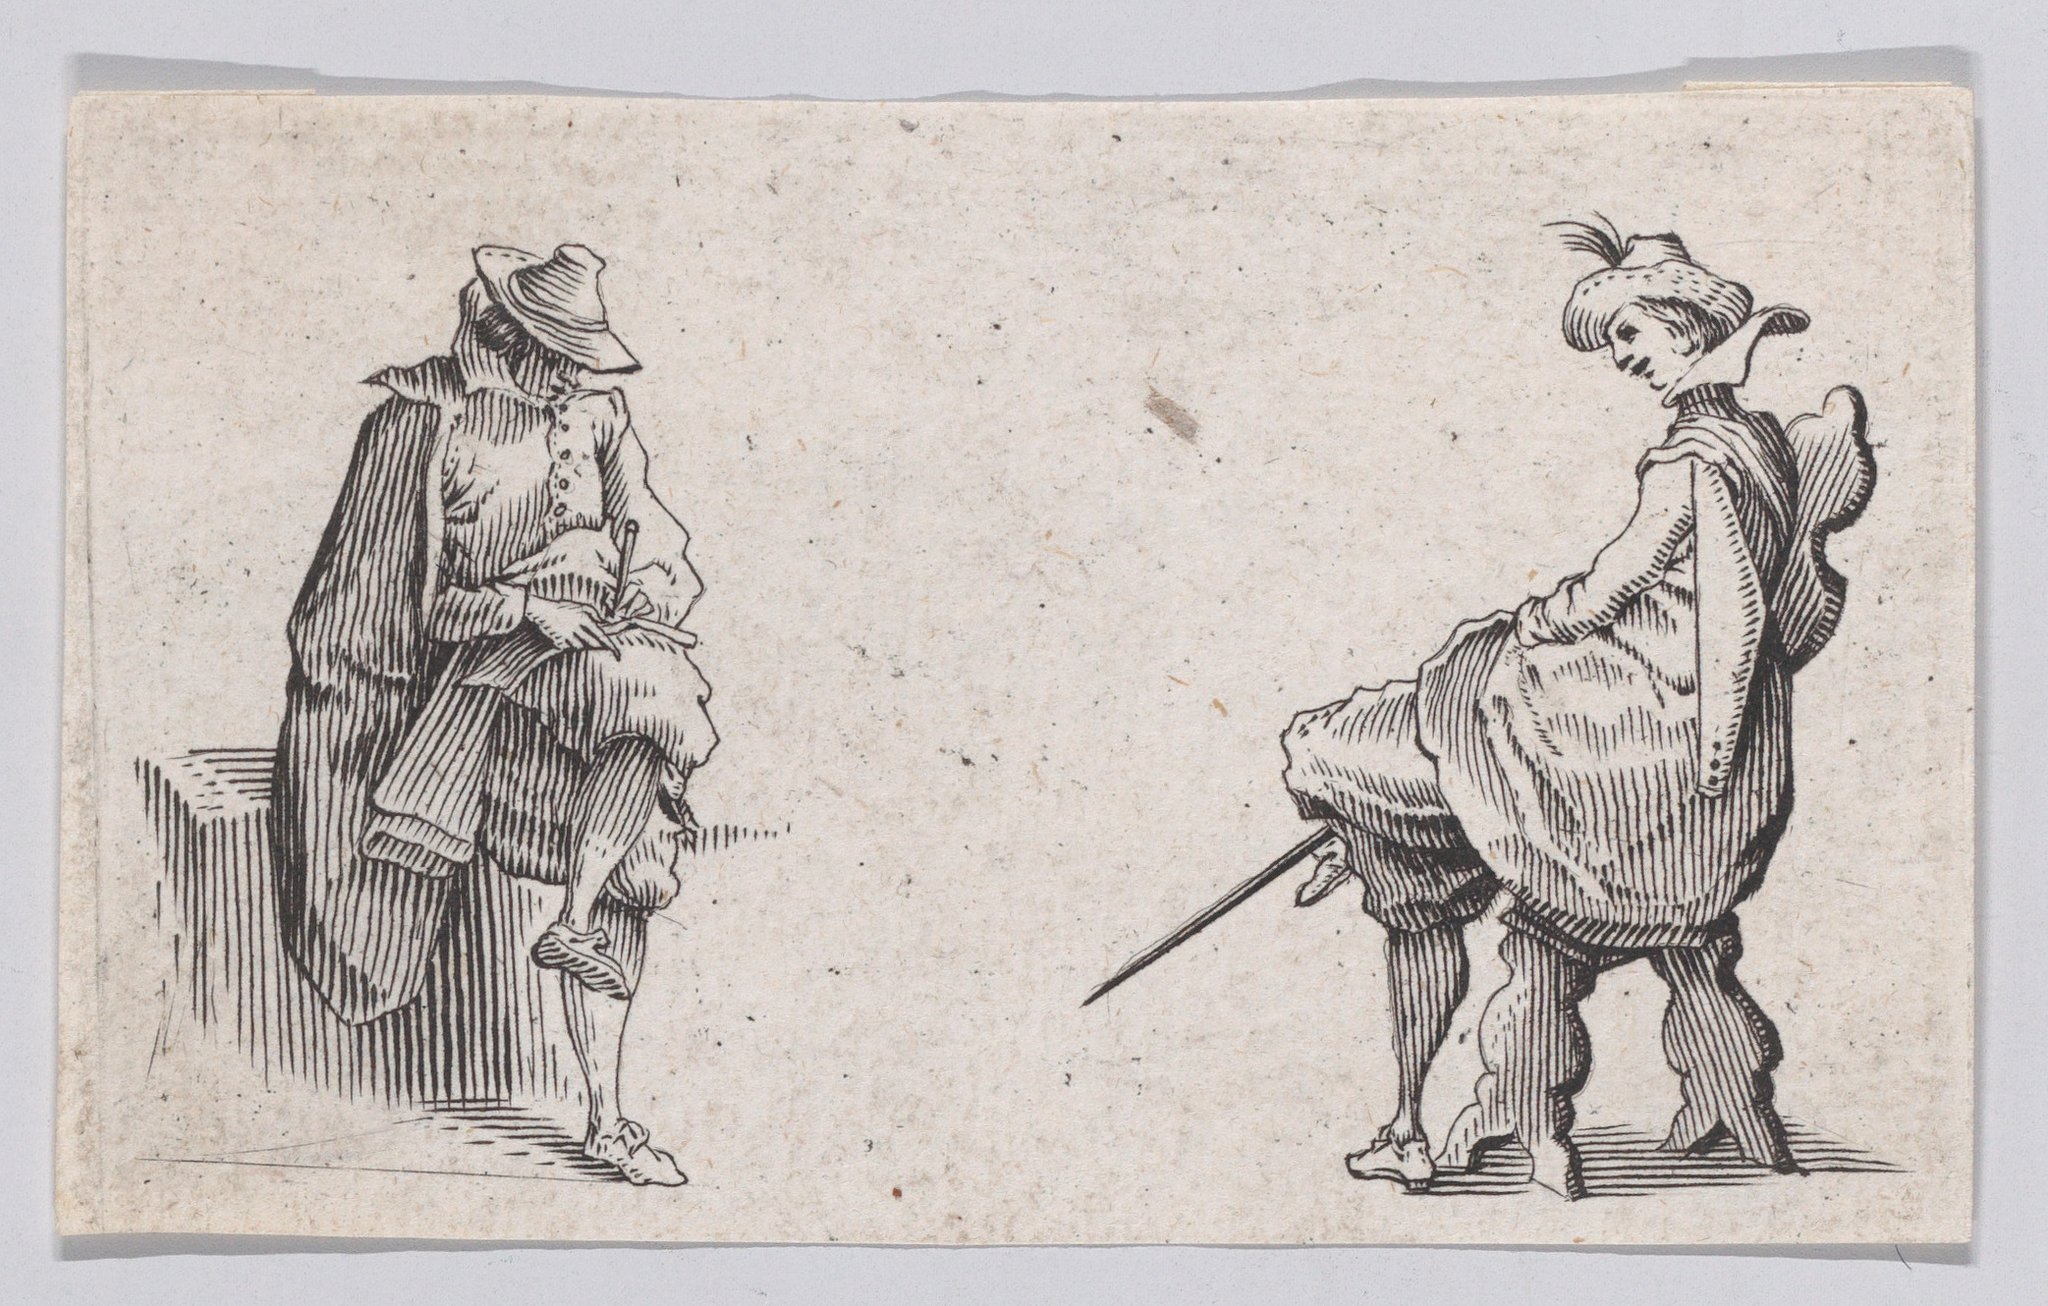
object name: print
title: Reverse Copy of Les Deux Personnages Assis (The Two Seated People), from "Les Caprices" Series A, The Florence Set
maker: Anonymous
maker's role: artist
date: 1601-1700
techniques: etching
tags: men